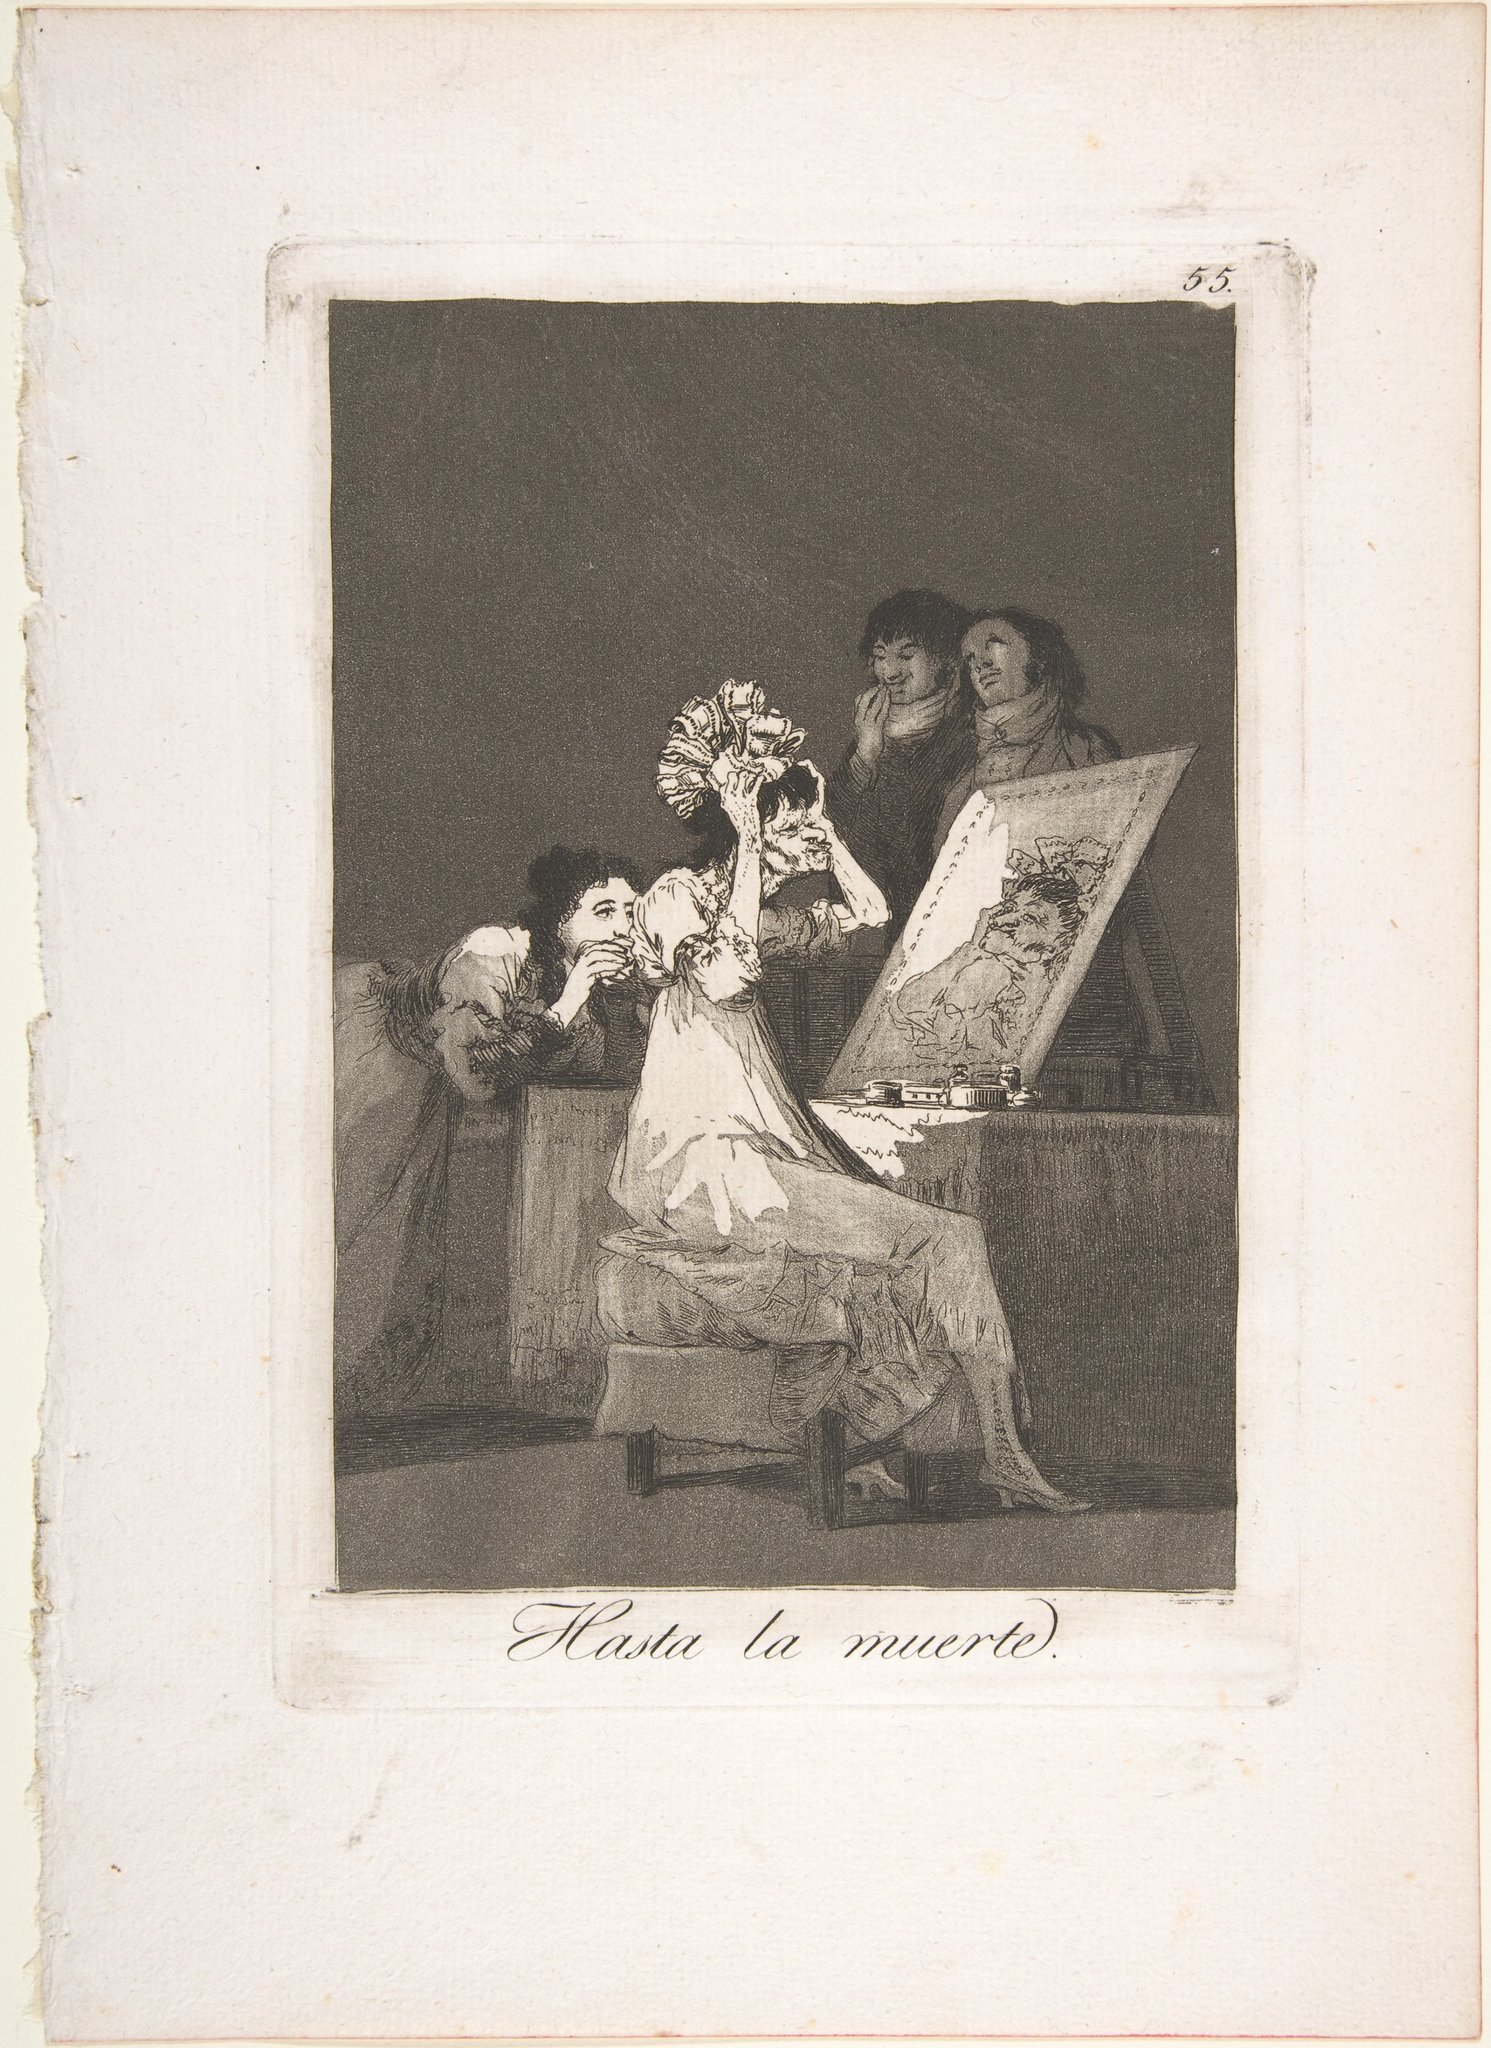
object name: print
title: Plate 55 from "Los Caprichos": Until death (Hasta la muerte)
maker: goya (francisco de goya y lucientes)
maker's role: artist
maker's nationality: spanish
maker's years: 1746-1828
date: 1799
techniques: aquatint, burnishing, drypoint, etching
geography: spain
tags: men,women,mirrors